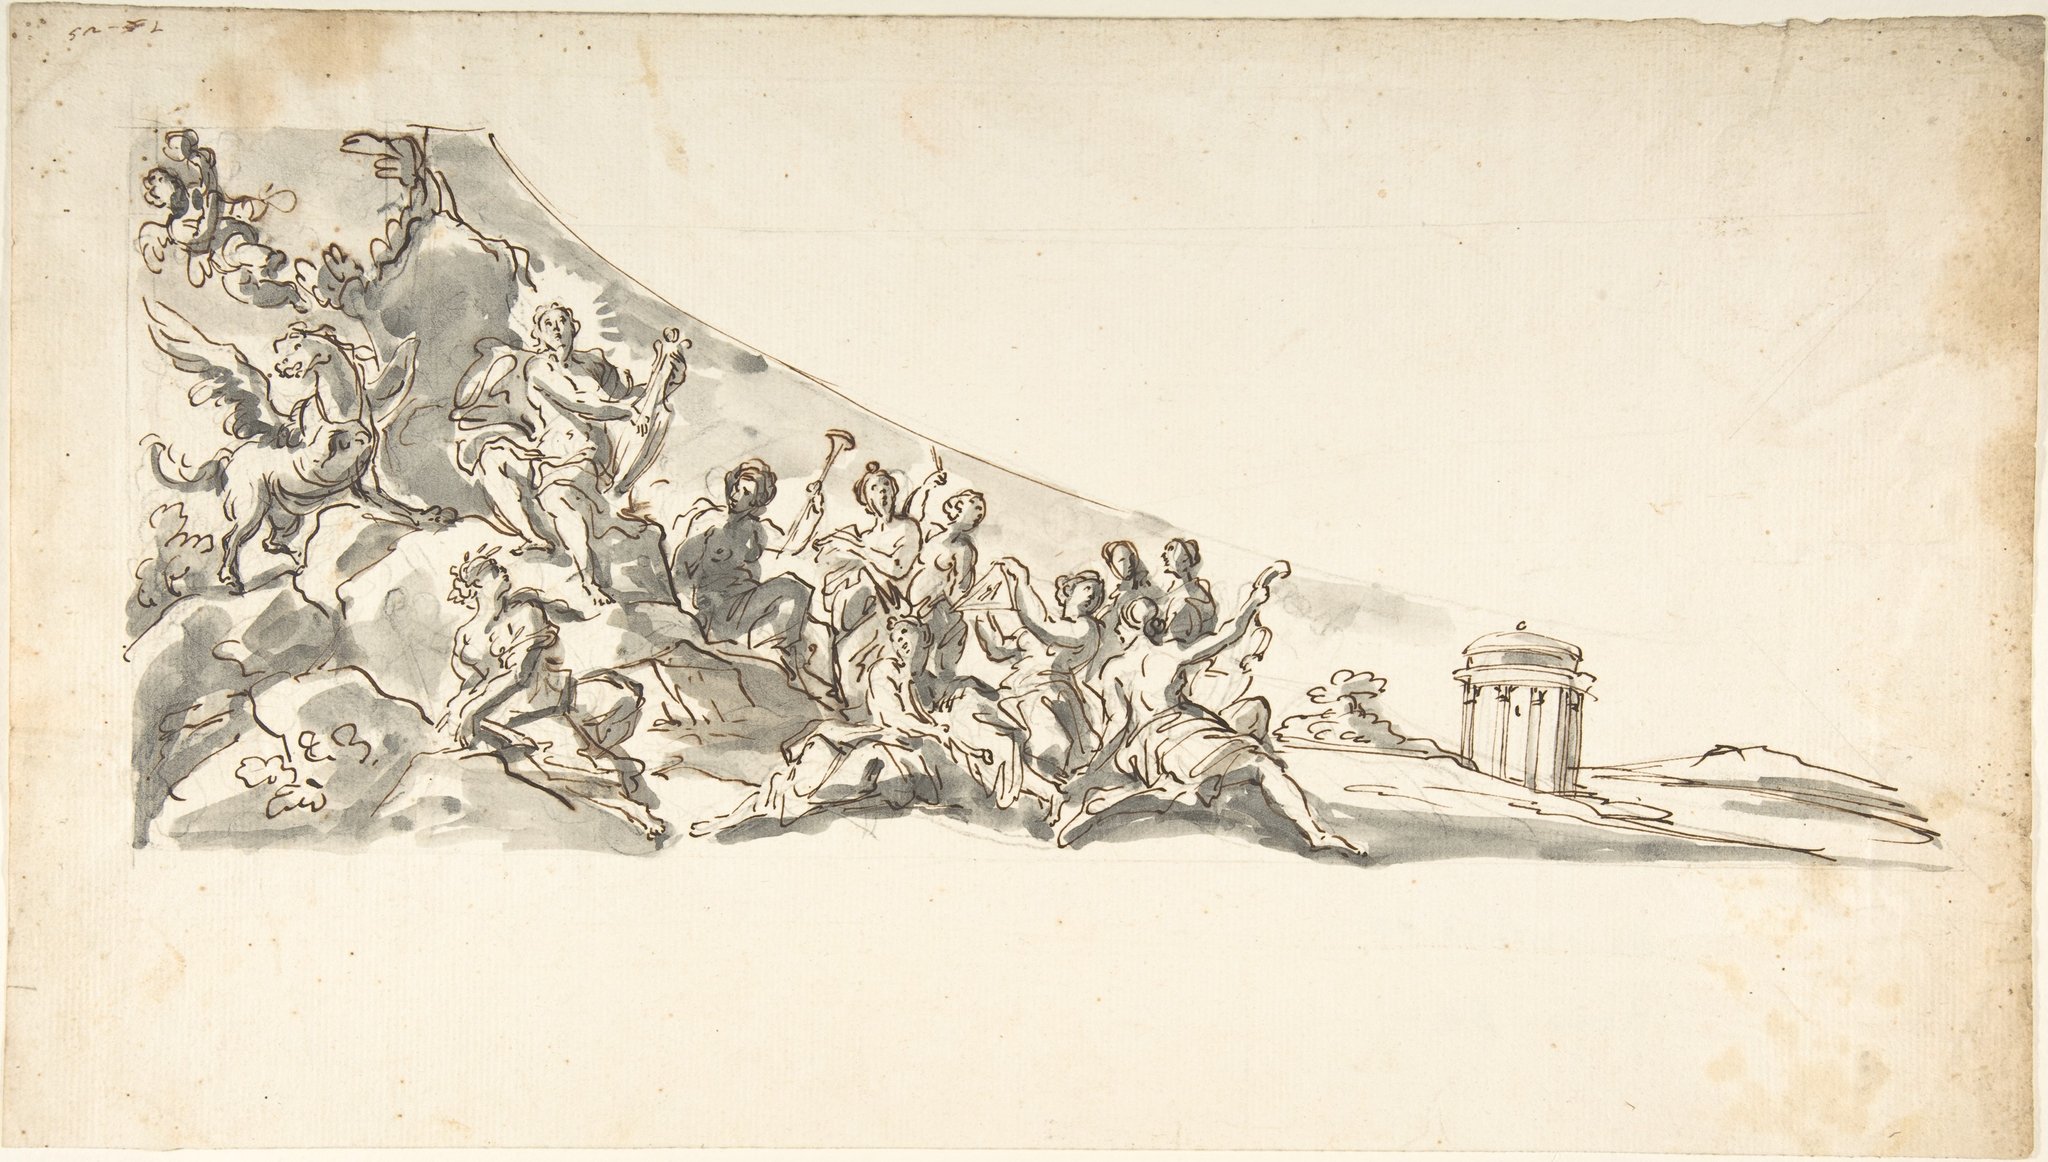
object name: drawing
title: Drawing for a Harpsichord Top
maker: anonymous, italian, 18th century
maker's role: artist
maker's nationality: italian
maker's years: 1700-1800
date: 1701-1800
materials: graphite, ink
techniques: brush, pen, wash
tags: female nudes